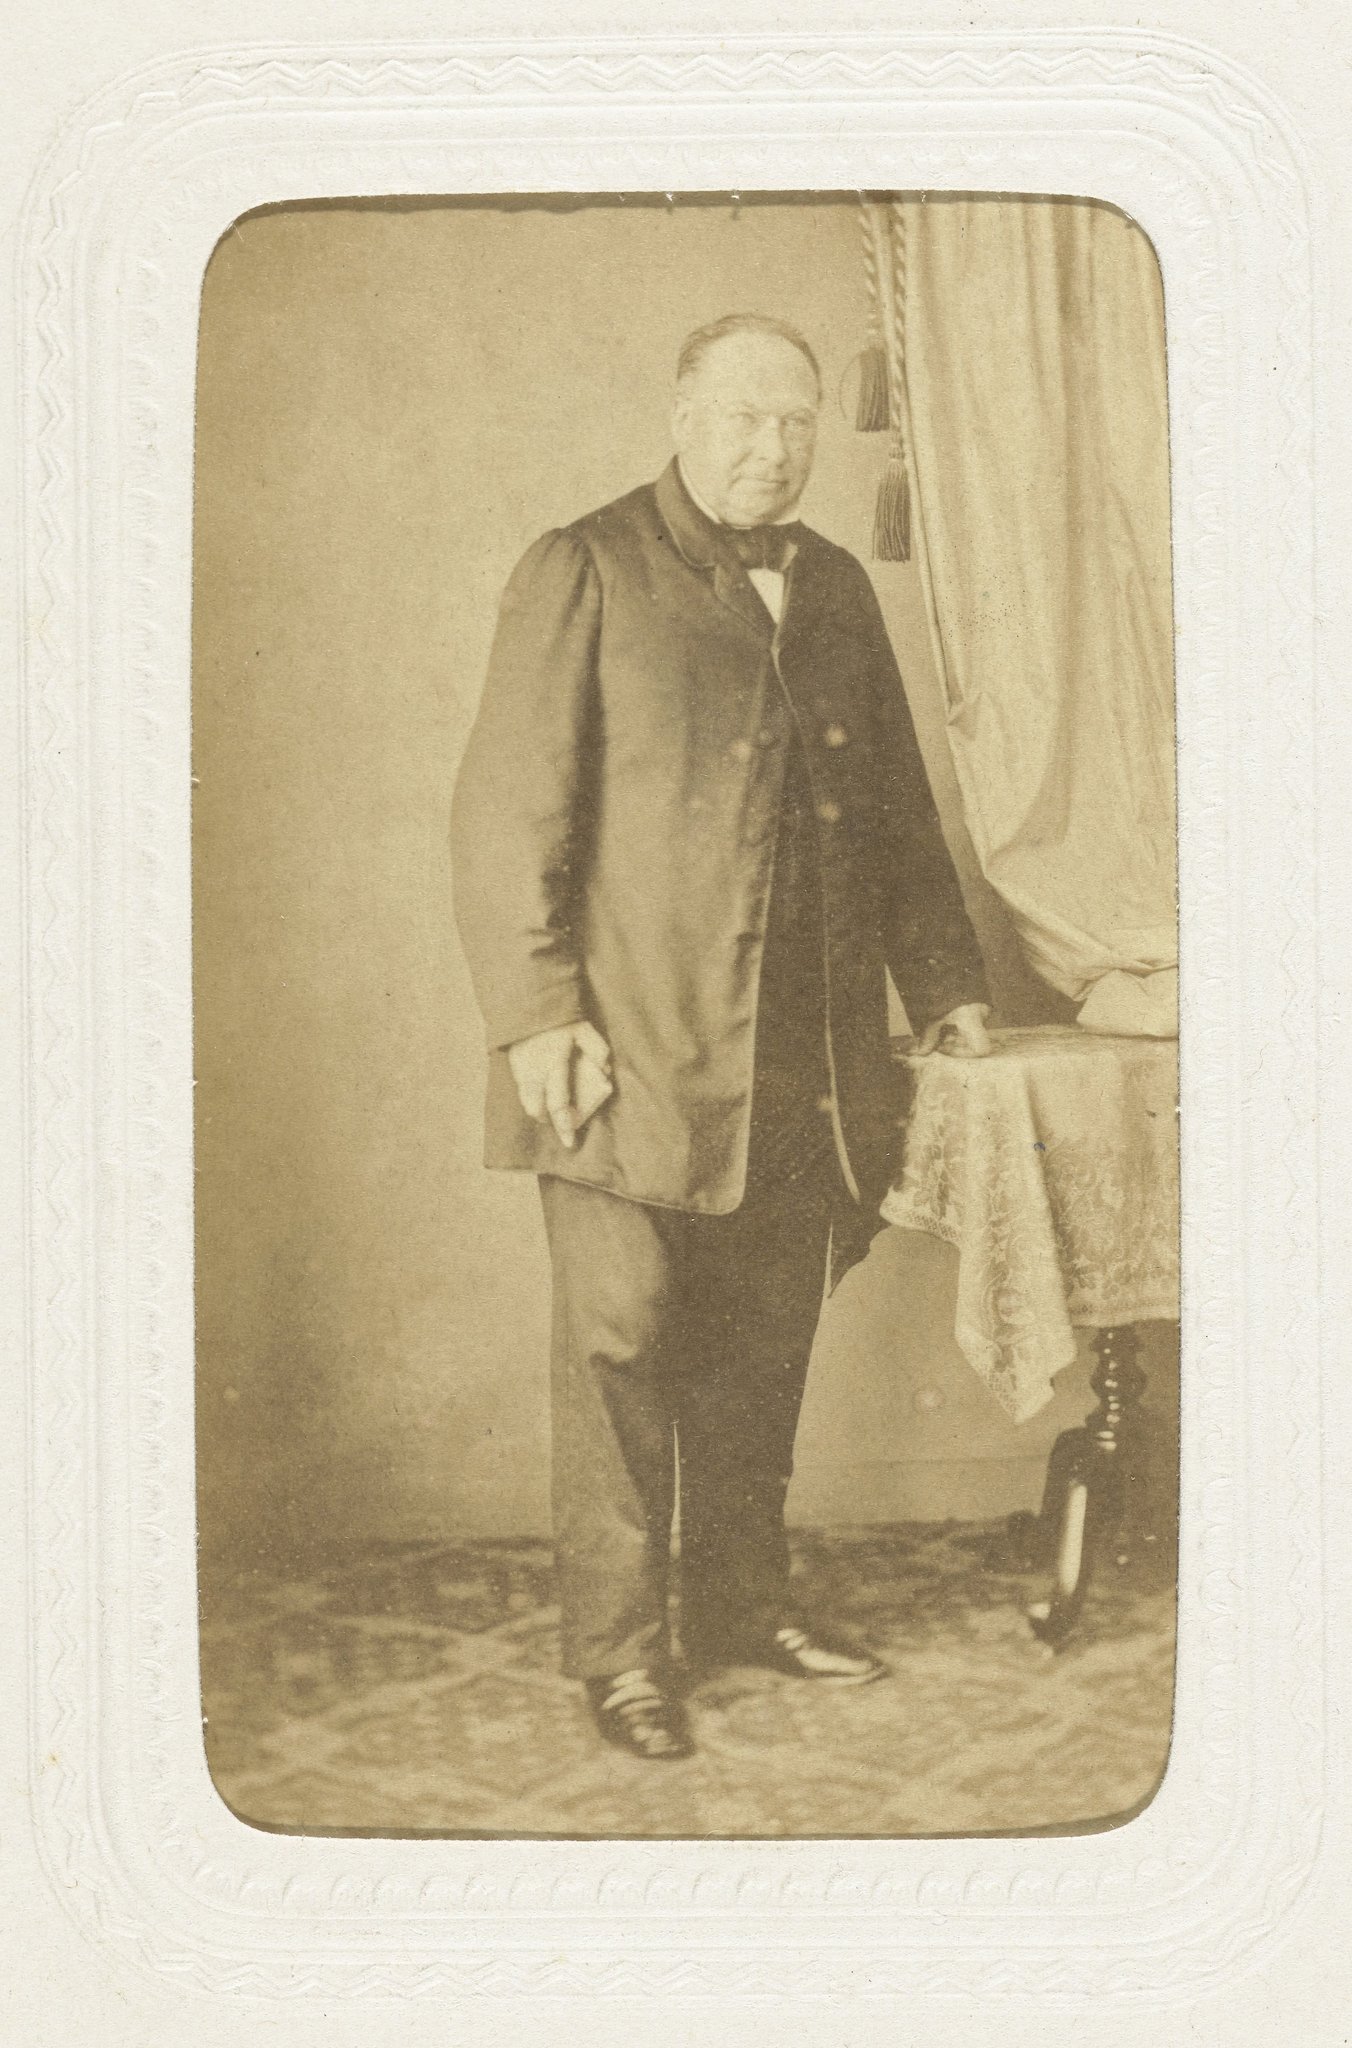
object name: carte de visite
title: Studioportret van een man naast een tafel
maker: Anonymous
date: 1863-1866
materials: cardboard, paper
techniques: albumen print